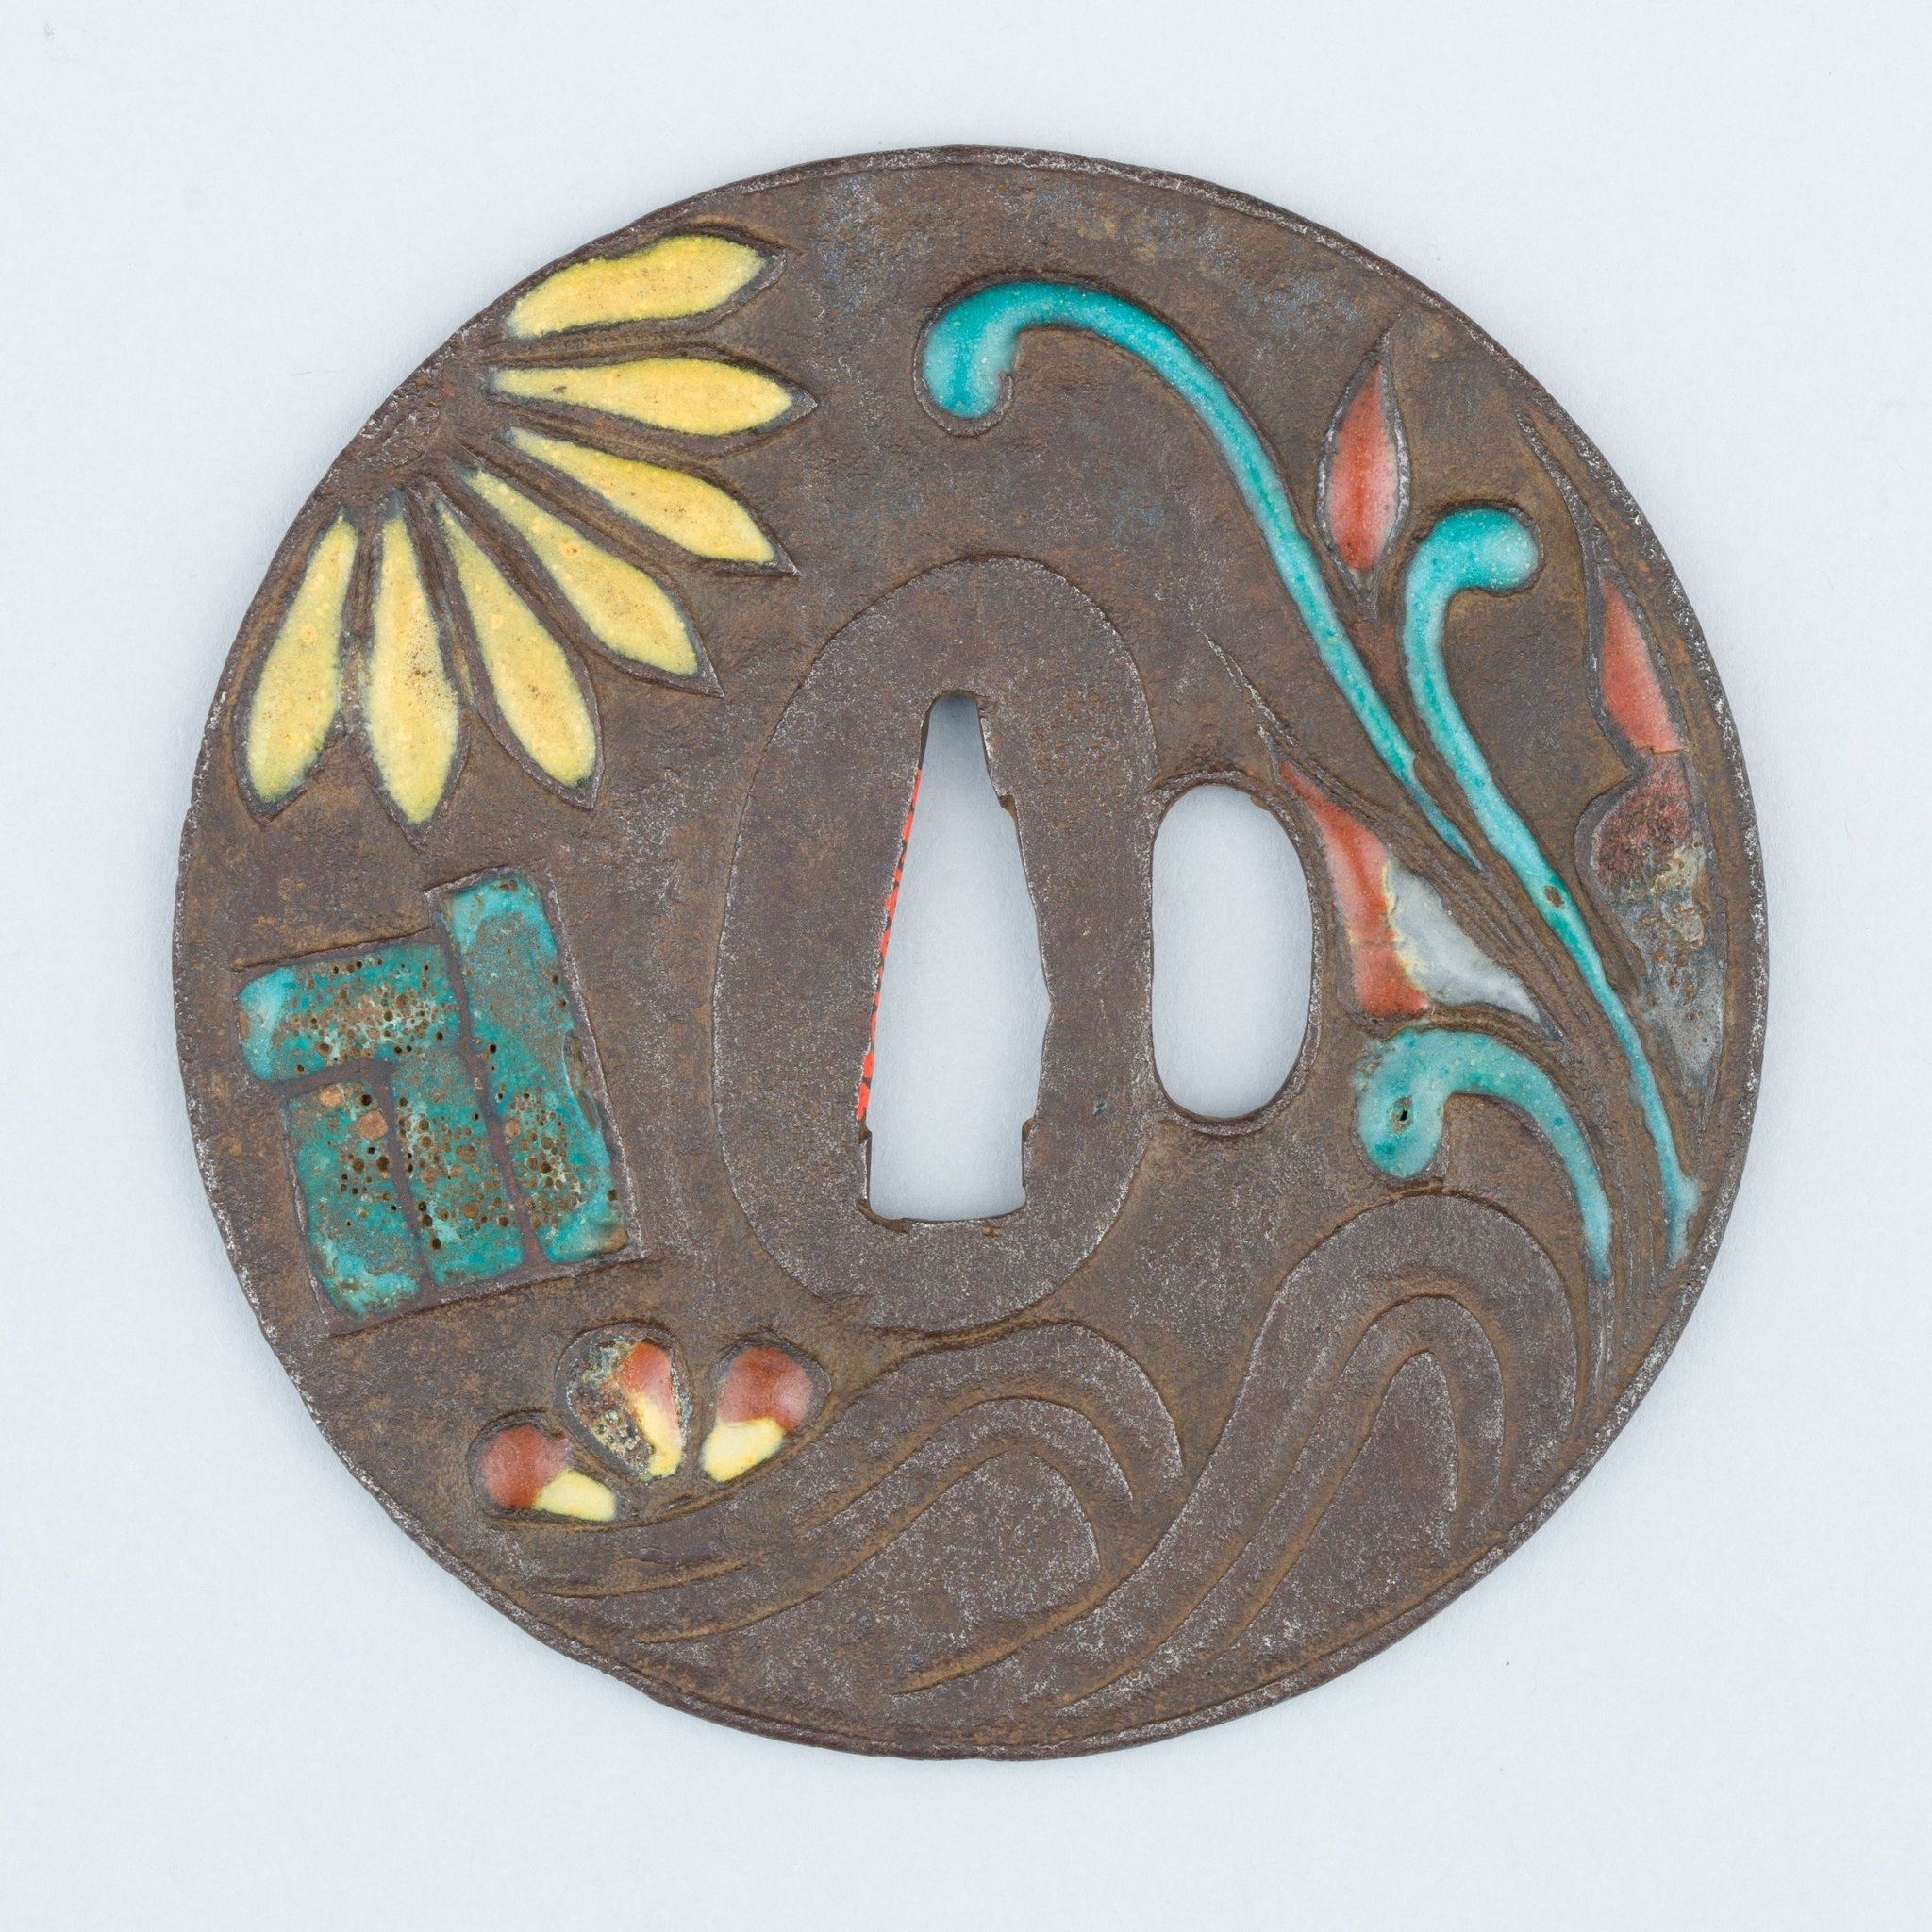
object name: sword guard tsuba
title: Sword Guard (Tsuba)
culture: japanese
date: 1615-1868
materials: copper, enamel, iron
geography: japan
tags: flowers